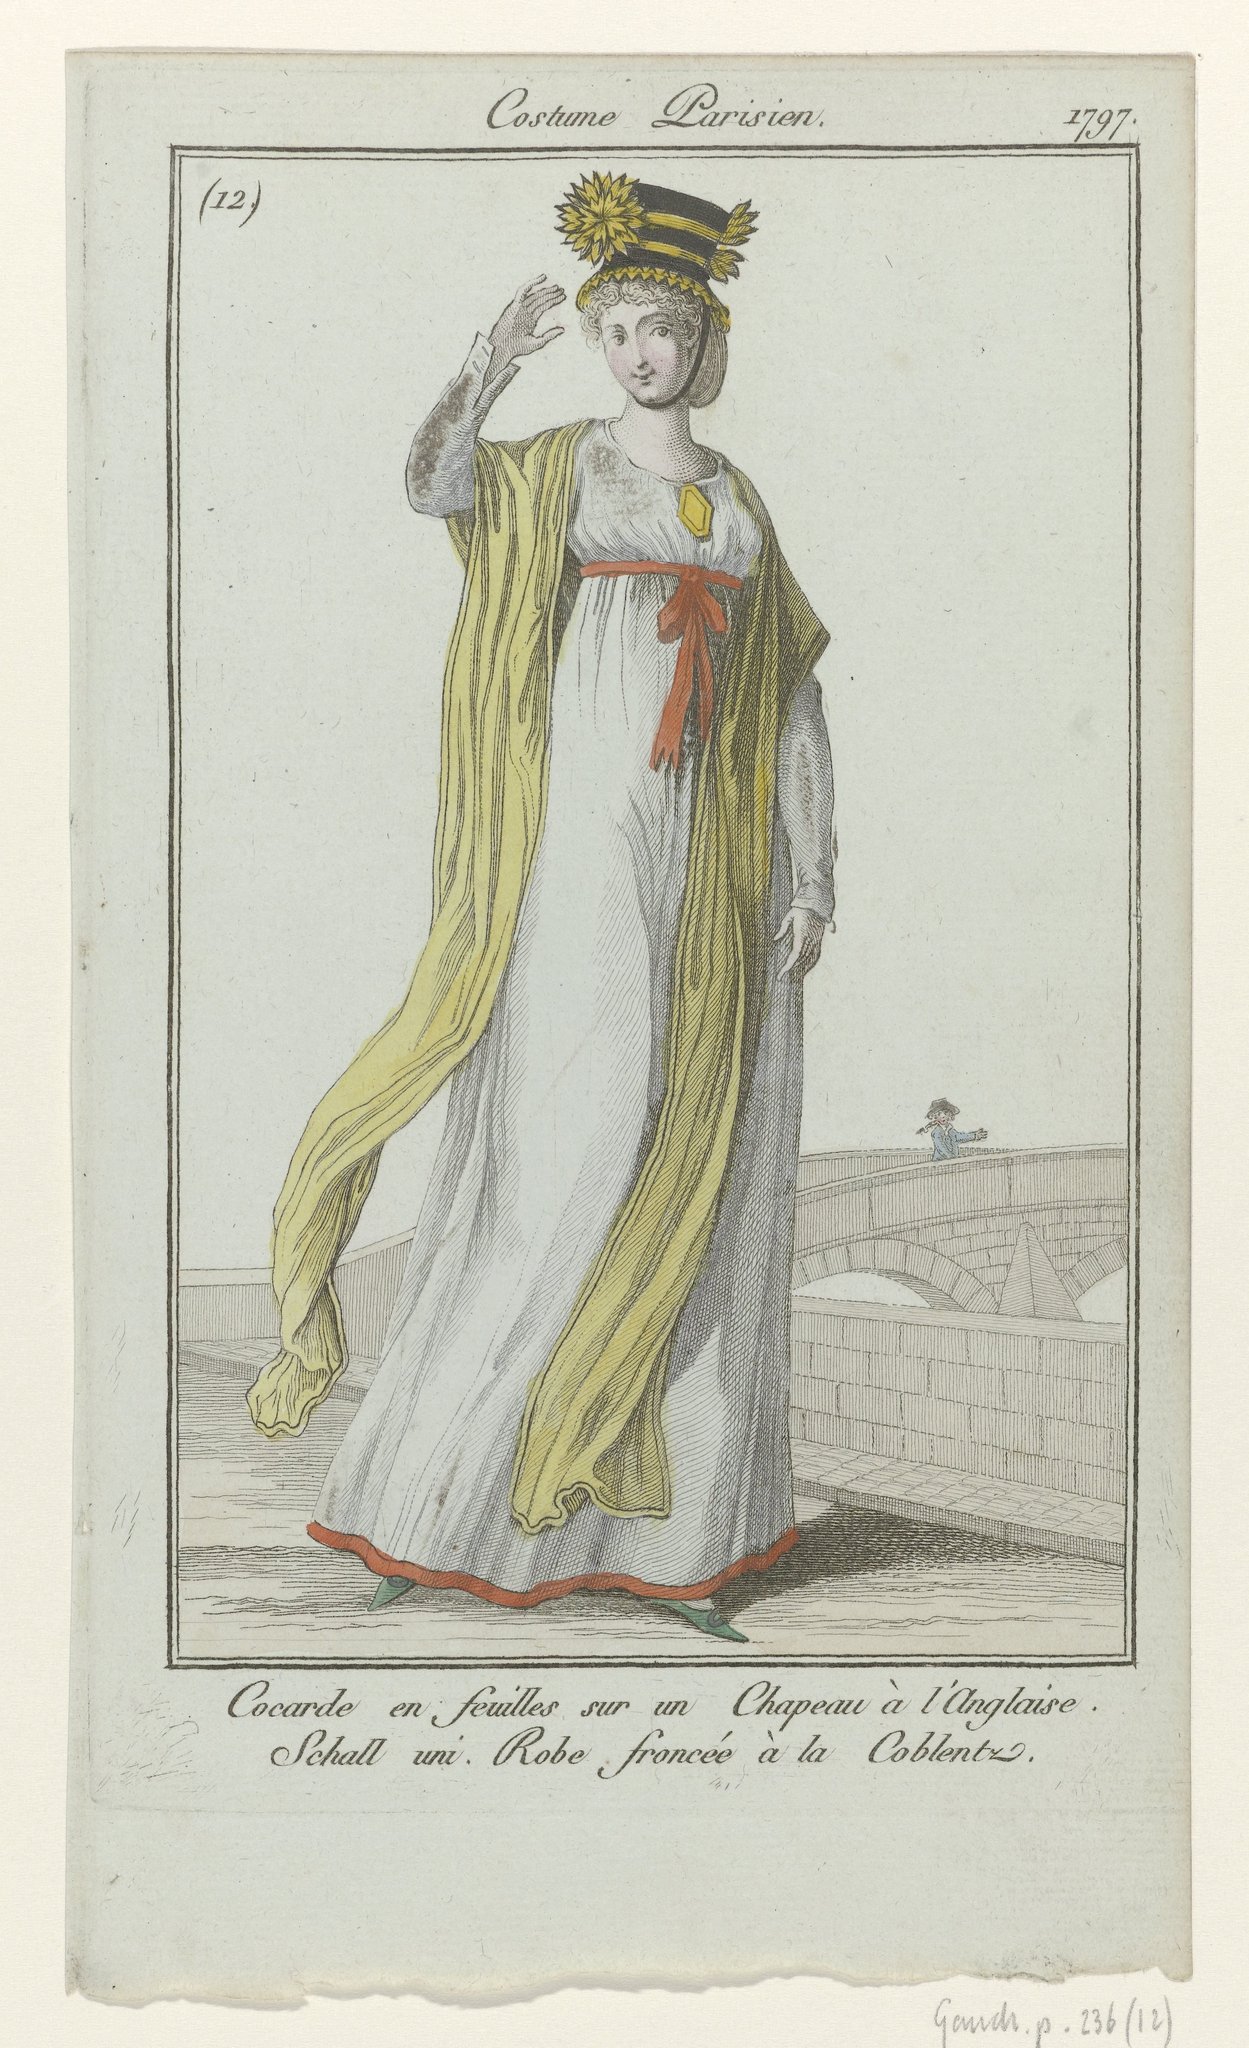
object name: fashion print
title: Journal des Dames et des Modes, Costume Parisien, 25 novembre 1797, (12) : Cocarde en feuilles (...)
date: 1797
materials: paper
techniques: engraving, hand coloring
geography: paris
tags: brooch, agraffe, clasp (+ women's clothes), clothing for the upper part of the body (shawl) (+ women's clothes), fashion plates, head-gear: hat (+ women's clothes), dress, gown (+ women's clothes), bridge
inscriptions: title: ‘Costume Parisien.’, caption: ‘Cocarde en feuilles sur un Chapeau à l'Anglaise. Schall uni. Robe froncée à la Coblentz.’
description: 'Chapeau à l'Anglaise' versierd met een kokarde van bladeren. Om de schouders een effen lange sjaal. Japon, gesmockt 'à la Coblentz', met gestrikt lint om de hoge taille, afgezet met een gekleurde bies. Verdere accessoires: ruitvormige broche (?), platte schoenen met puntige neuzen en ronde gespen (?). De prent maakt deel uit van het modetijdschrift Journal des Dames et des Modes, uitgegeven door Sellèque, Parijs, 1797-1839.